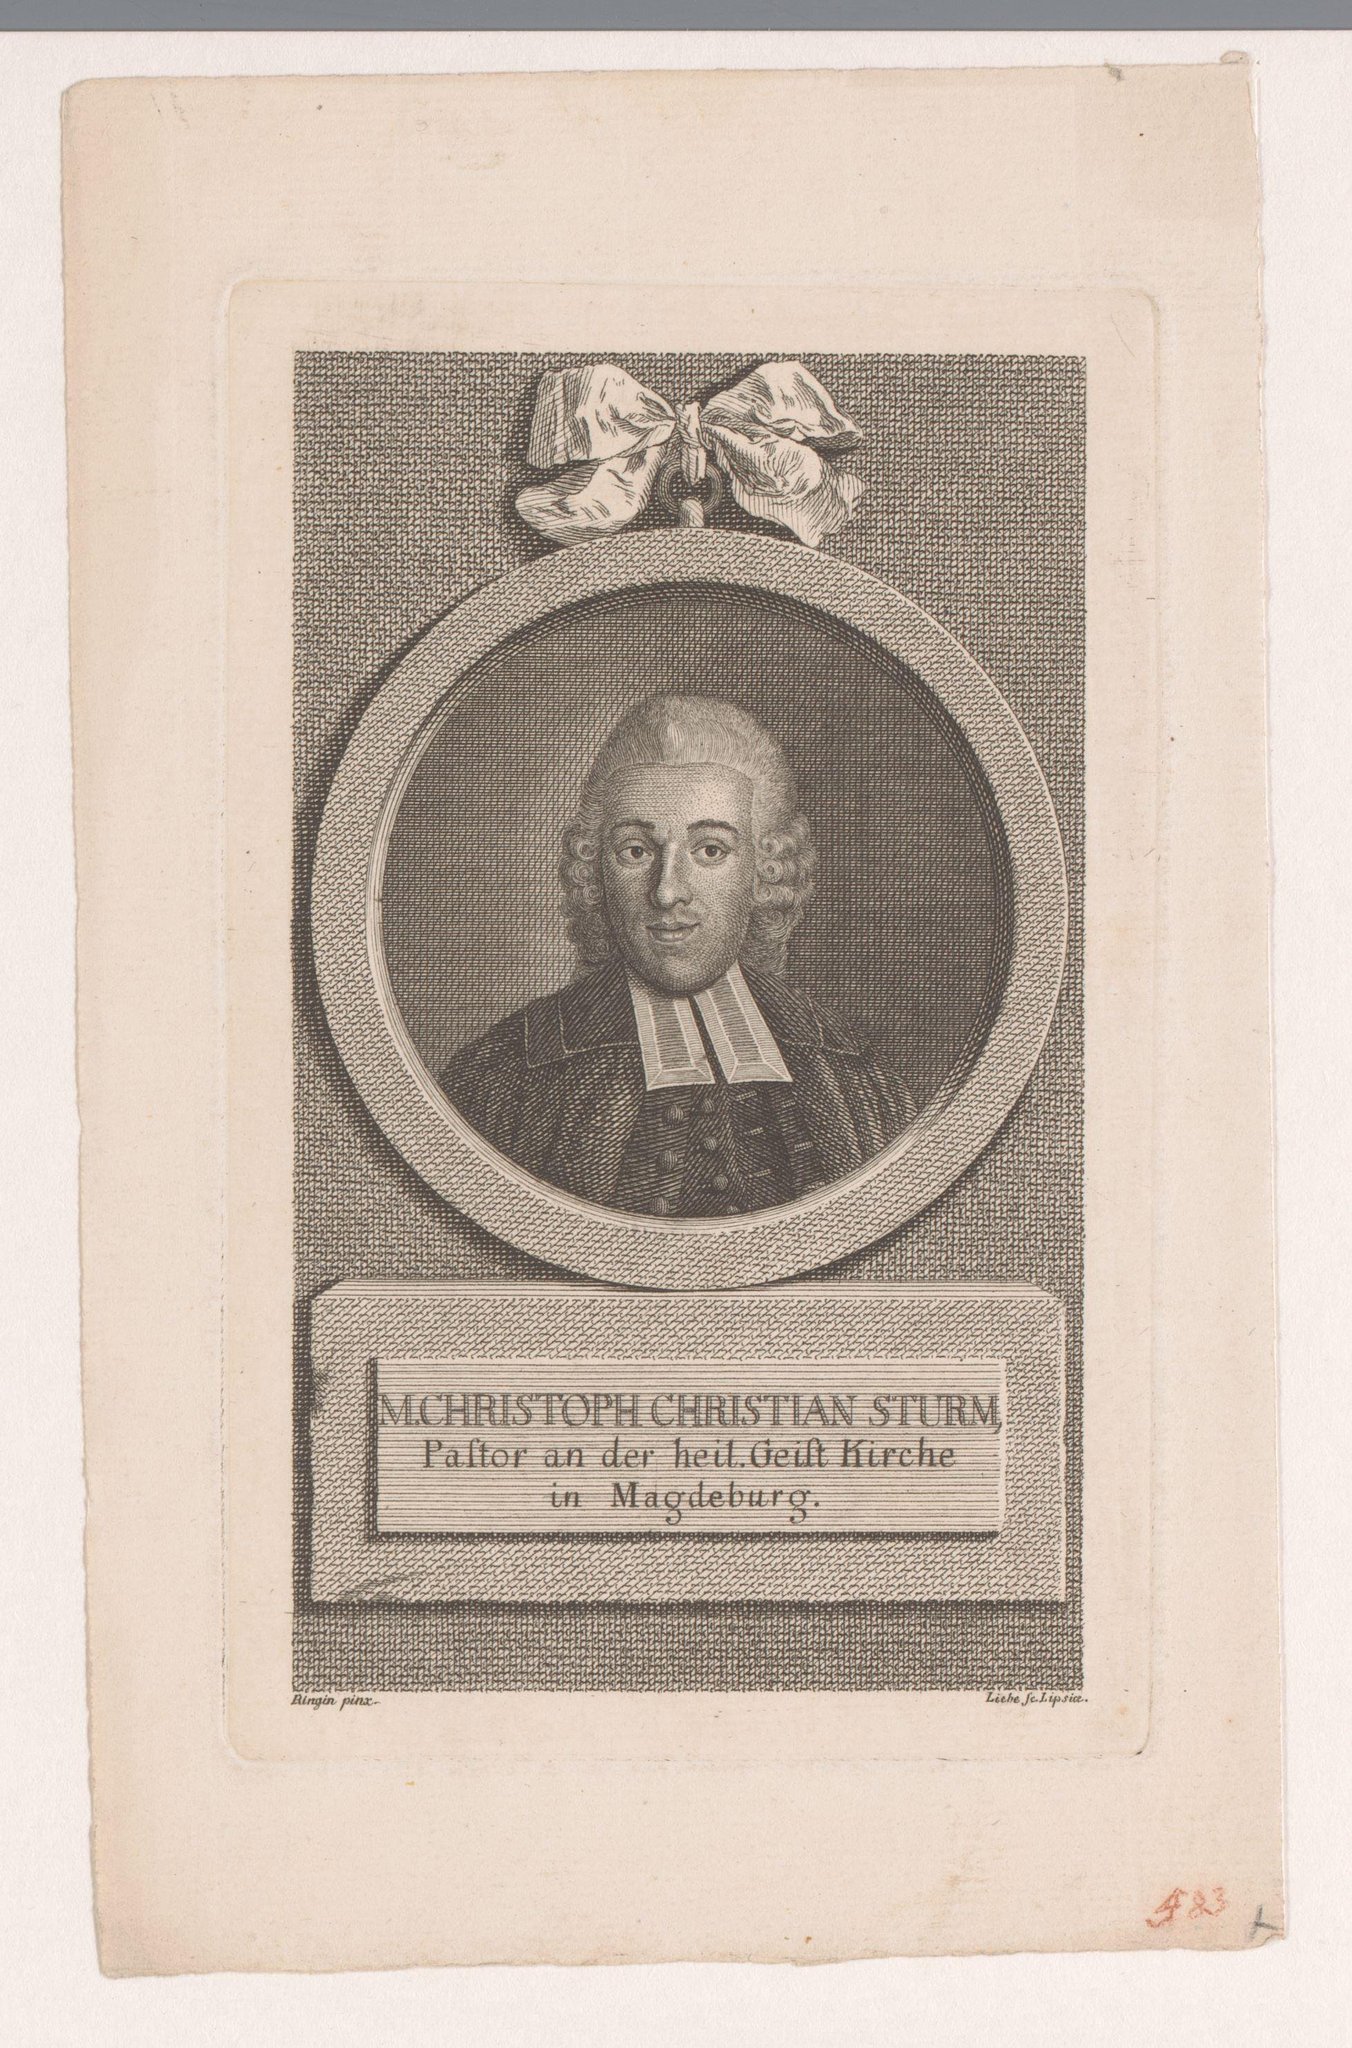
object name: print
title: Portret van Christoph Christian Sturm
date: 1769-1819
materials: paper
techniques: engraving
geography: leipzig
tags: augsburg, theologian, historical persons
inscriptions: collector's mark: Lugt 2228